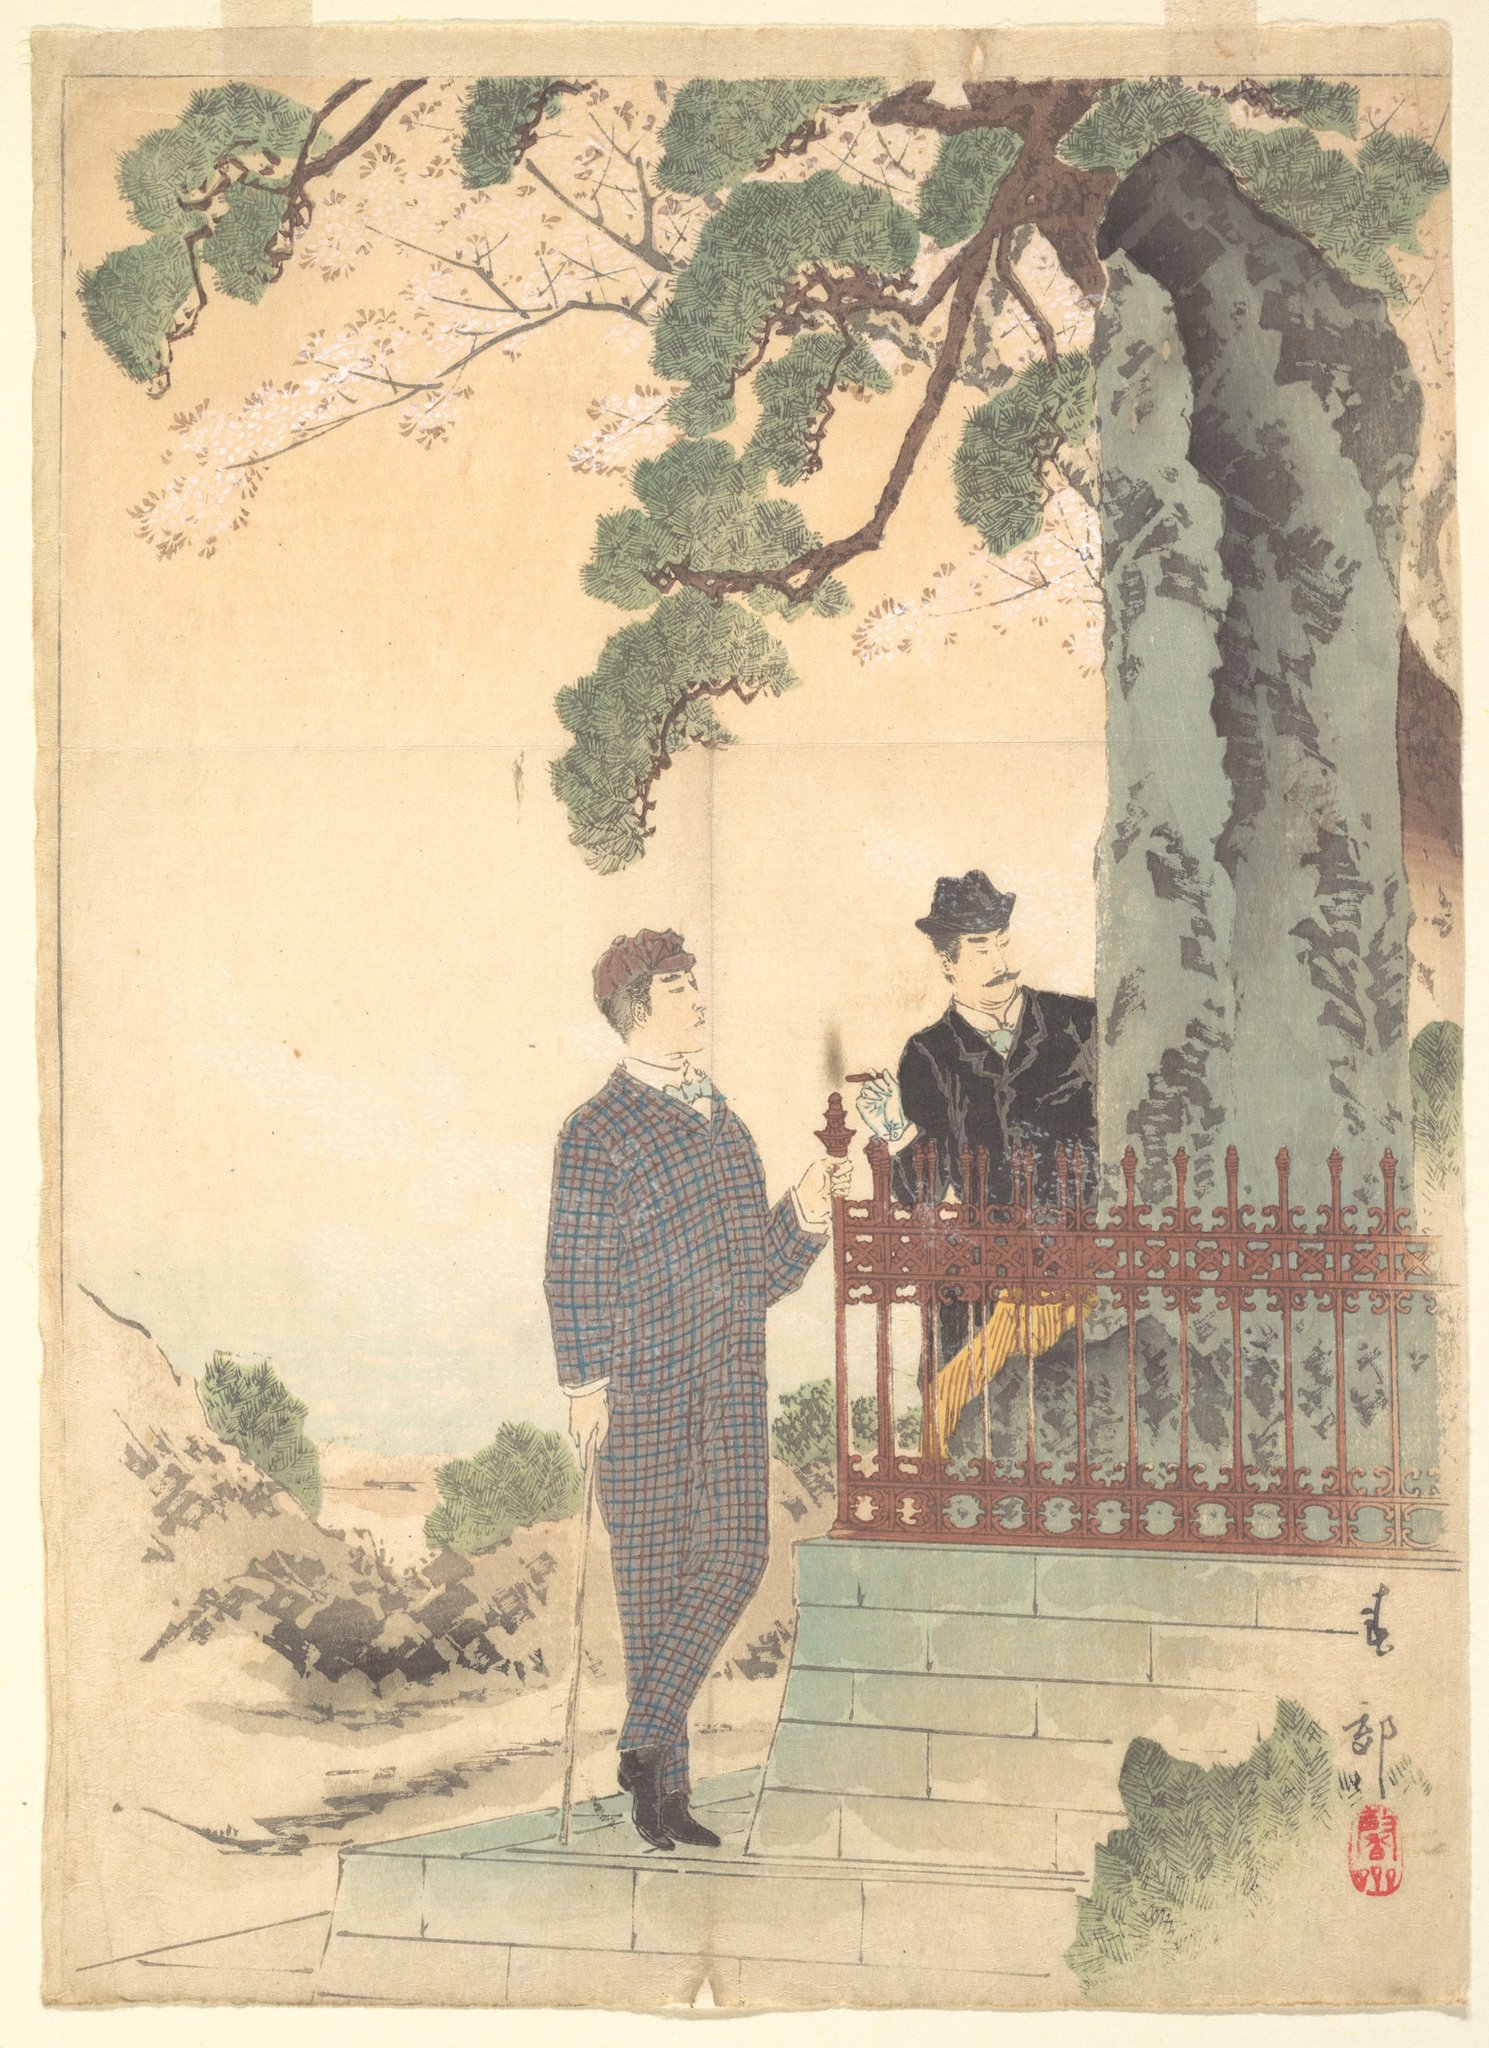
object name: print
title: Two Japanese Men in Western Dress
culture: japanese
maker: shunko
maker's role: artist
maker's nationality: japanese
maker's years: 1743-1800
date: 1905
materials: ink, paper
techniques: woodblock print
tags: men,smoking